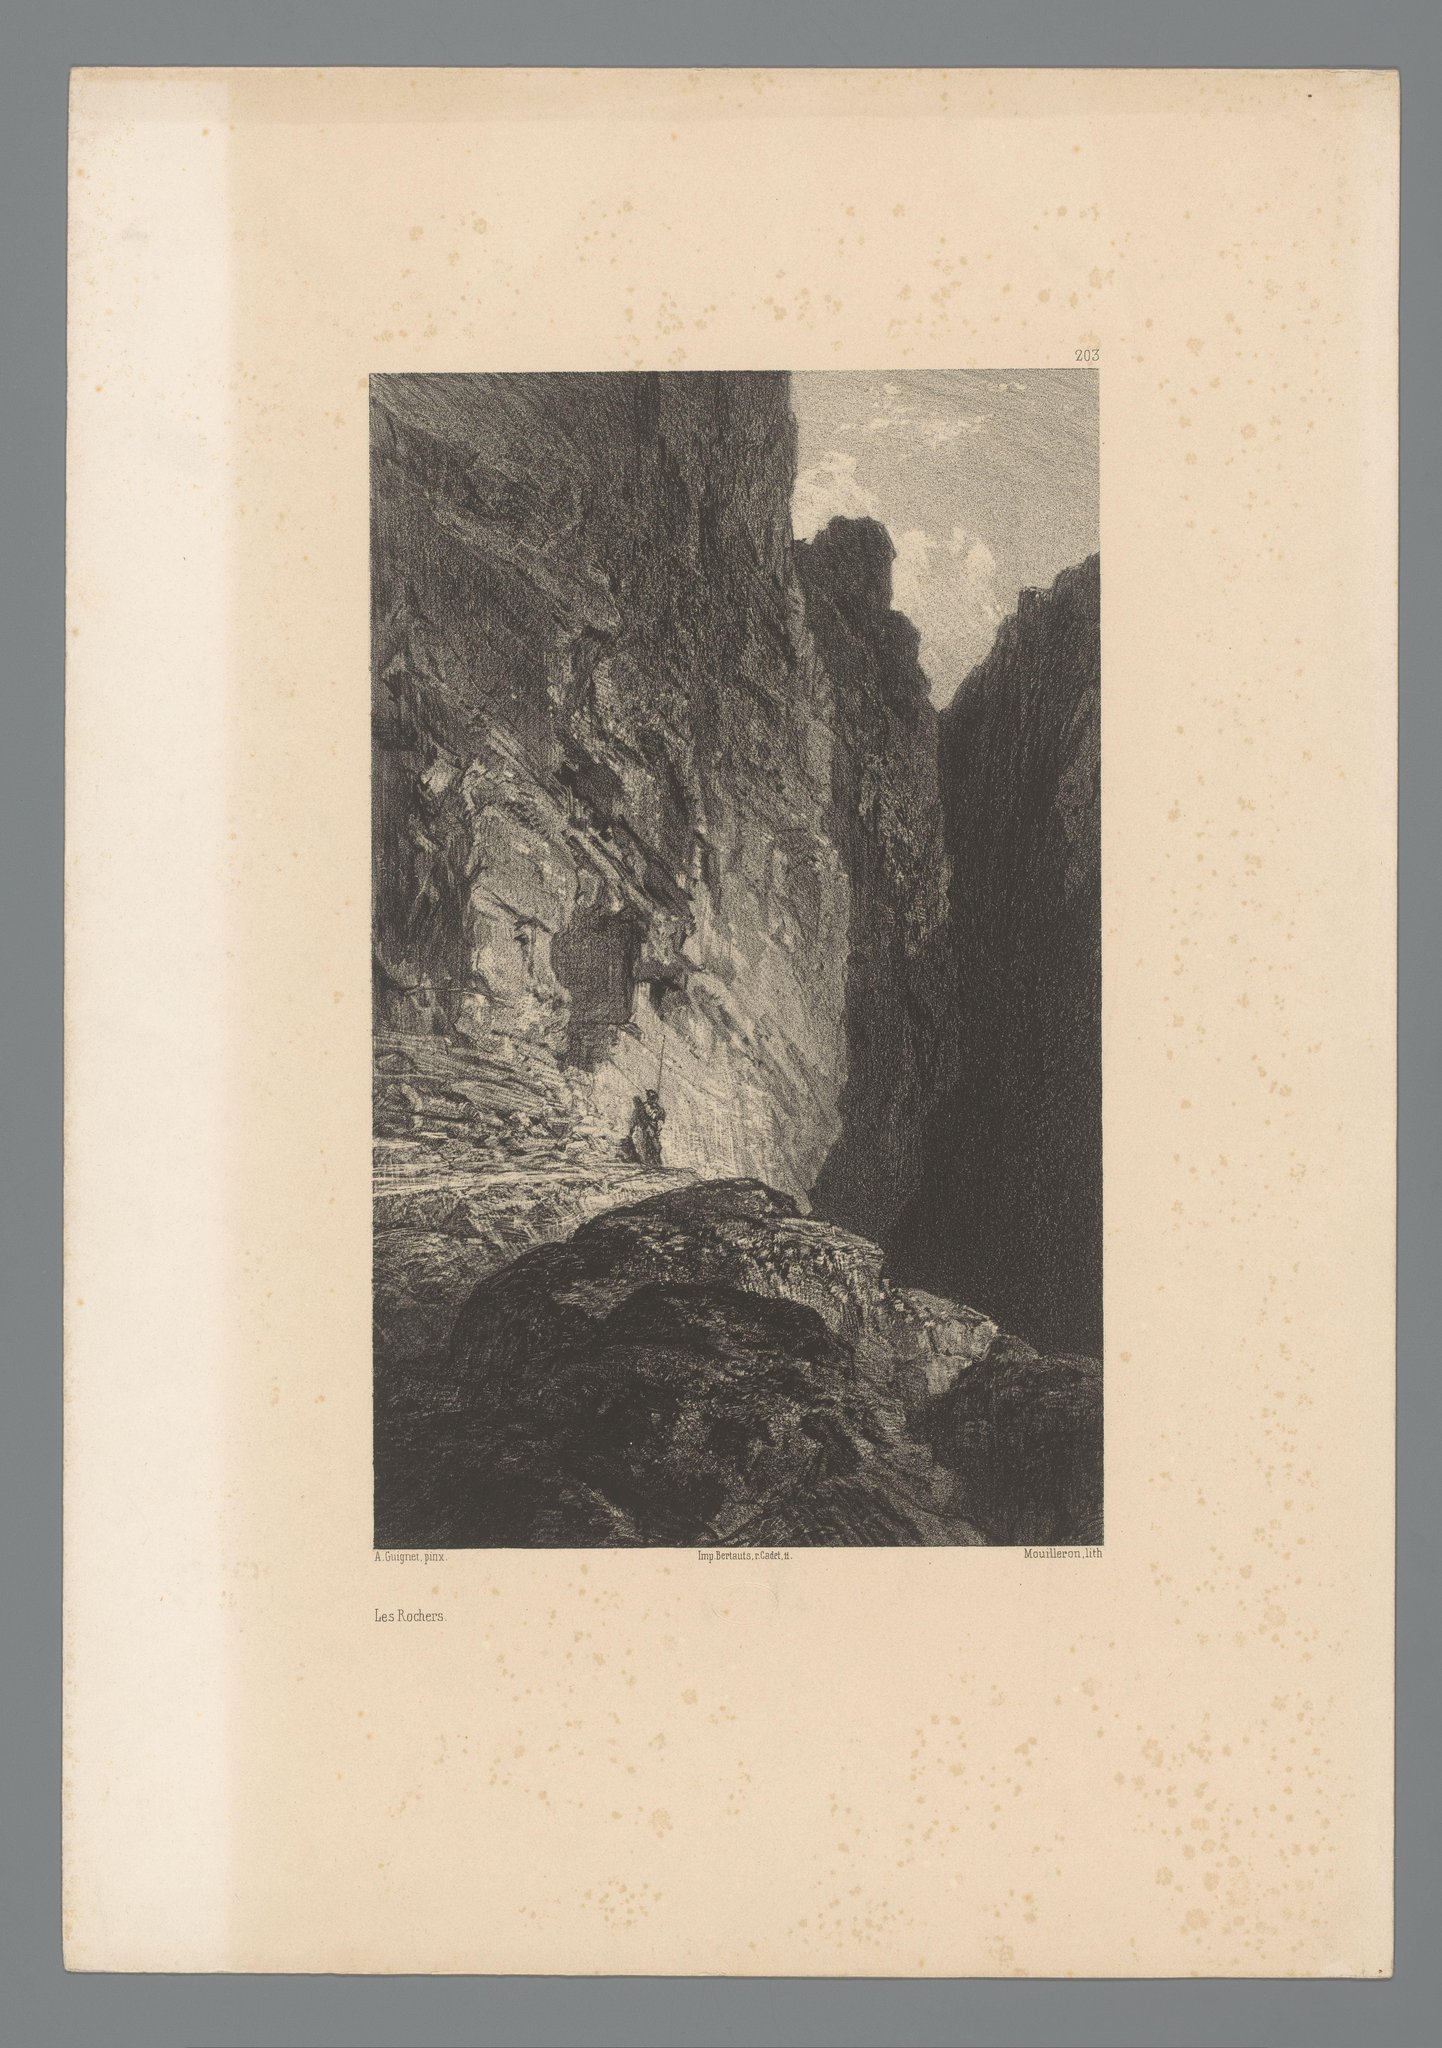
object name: print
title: Grotingang met schildwacht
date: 1851-1862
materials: paper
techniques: lithograph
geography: paris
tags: cave, grotto, guard duty, keeping sentry, rocks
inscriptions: collector's mark: Lugt 2233, check stamp: Lugt 36a, inscription: ‘Aug Allebé’